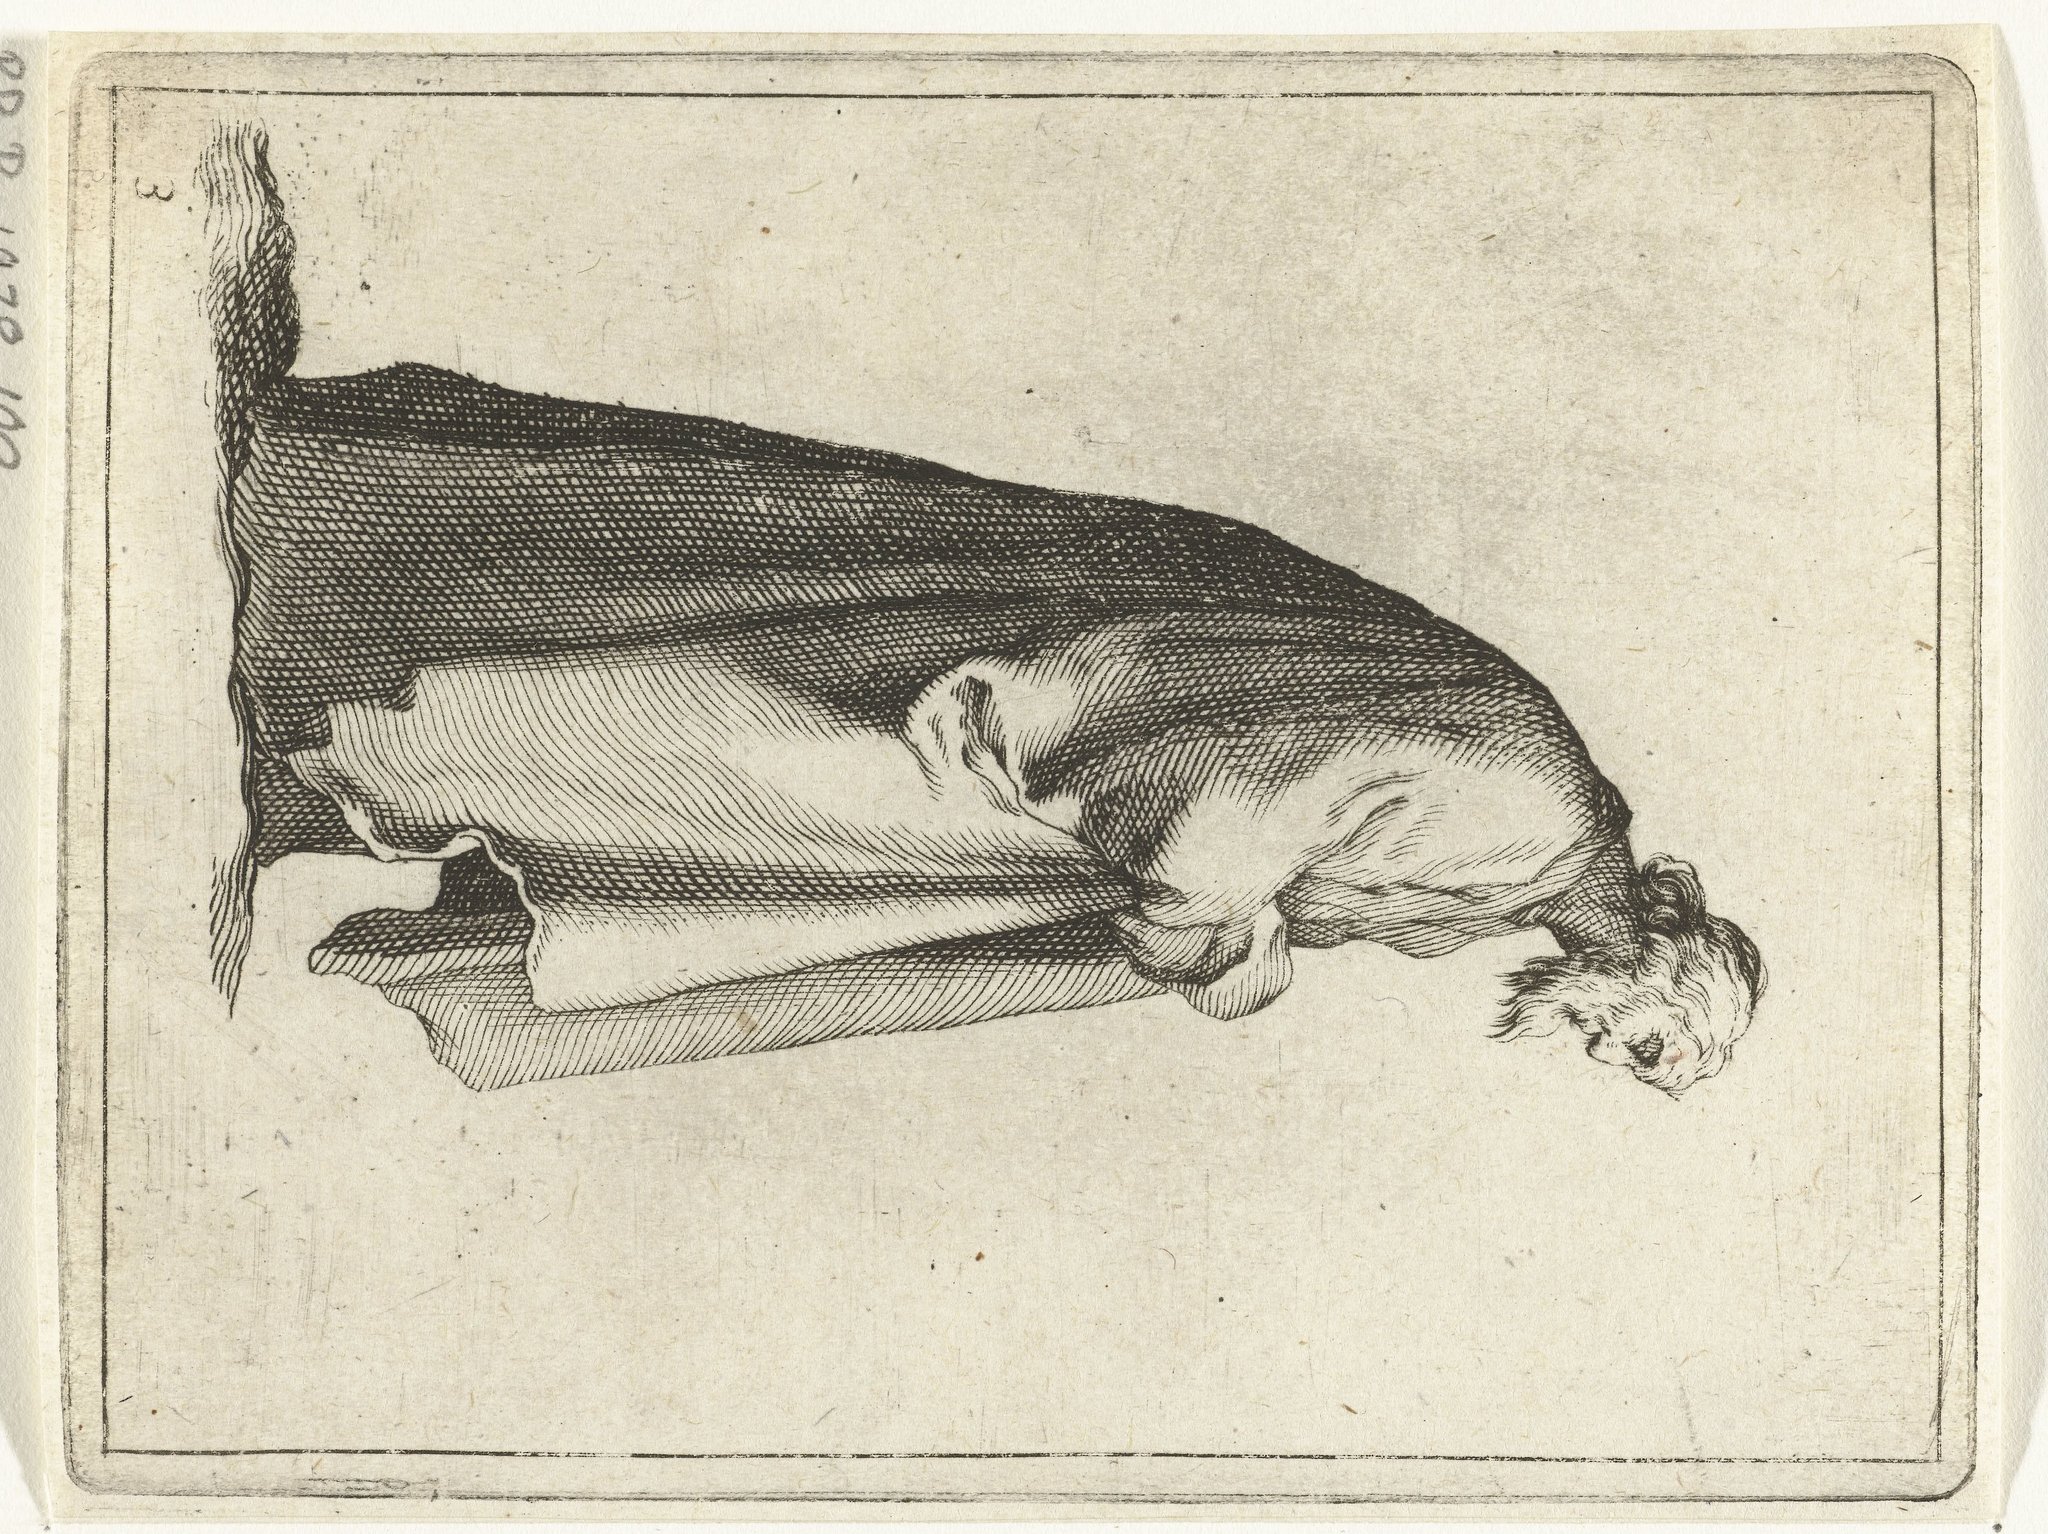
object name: print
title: Oude man met lange jas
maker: frederick bloemaert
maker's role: print maker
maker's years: 1614-1669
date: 1635-1669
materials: paper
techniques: engraving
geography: utrecht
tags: old man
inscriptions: collector's mark: Lugt 2228, collector's mark: Lugt 2760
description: Een oude man, zijwaarts afgebeeld, met ruim vallende kleding aan.